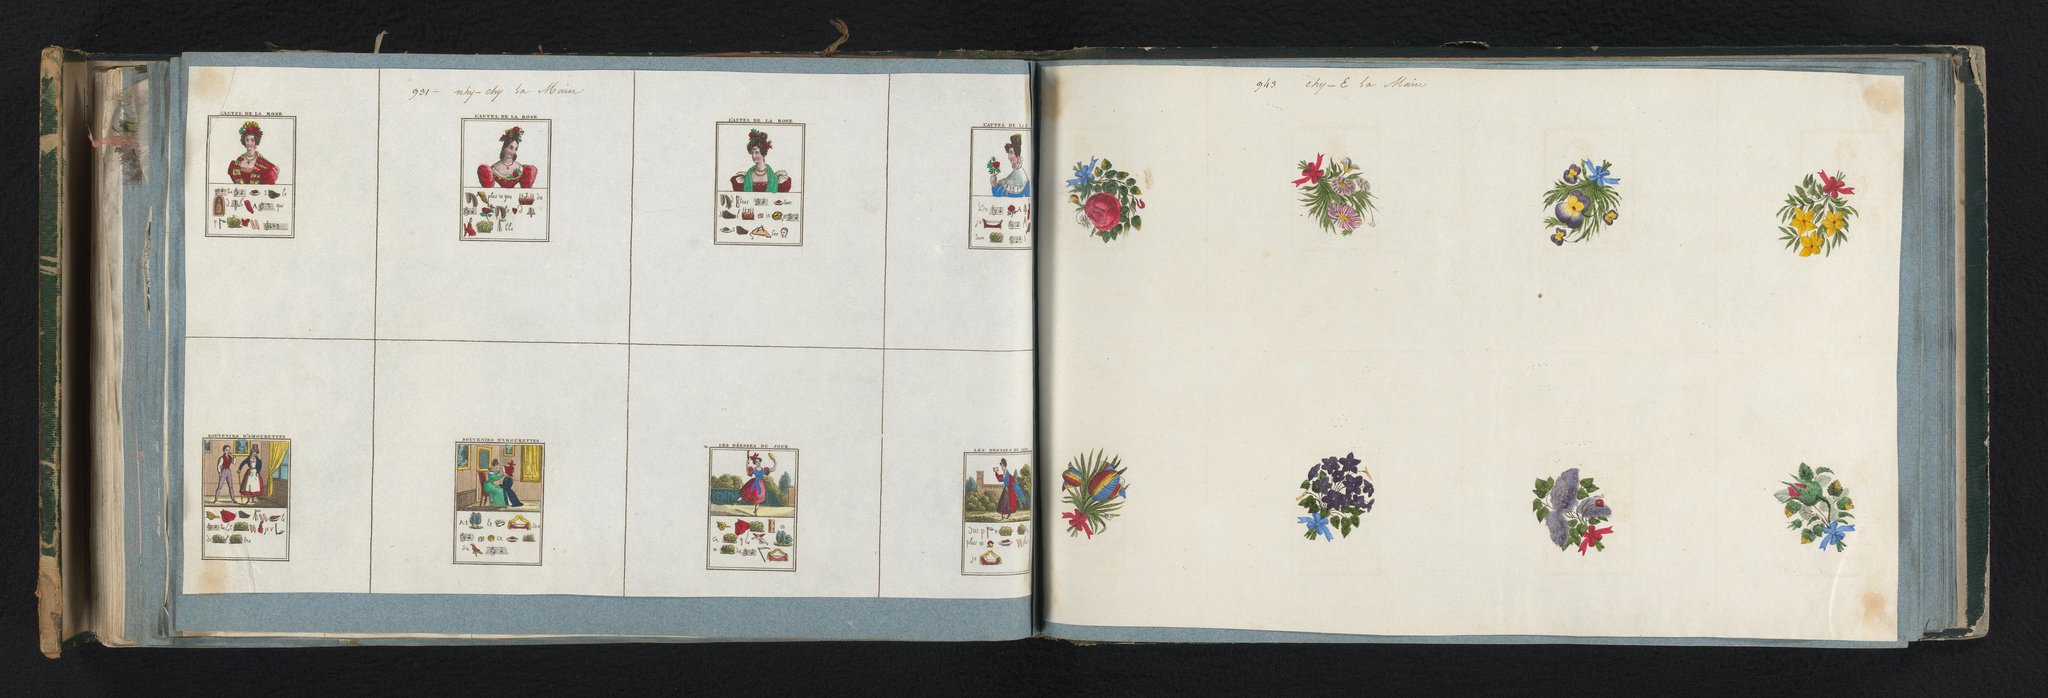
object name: album leaf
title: Twee bladzijden met bladen met vignetten met vrouwen en rebussen en bloemboeketten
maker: Anonymous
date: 1830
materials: ink, paper, watercolor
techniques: etching, hand coloring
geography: france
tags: cut flowers; nosegay, bunch of flowers, rebus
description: Twee bladzijden met links een ingeplakt blad waarop 8 gedrukte en ingekleurde vignetten van vrouwen met opschriften en een rebus. Rechts een ingeplakt blad met 8 gedrukte en ingekleurde vignetten van boeketten. Zonder de etiketten met nummers, maar de bladen genummerd 931 en 943 en voorzien van handgeschreven codes. Onderdeel van het stalenboek geschonken door de dames Van Rijn, vermoedelijk van een Franse papierfabrikant van luxe papieren, of diens vertegenwoordiger in Nederland, ca. 1830.